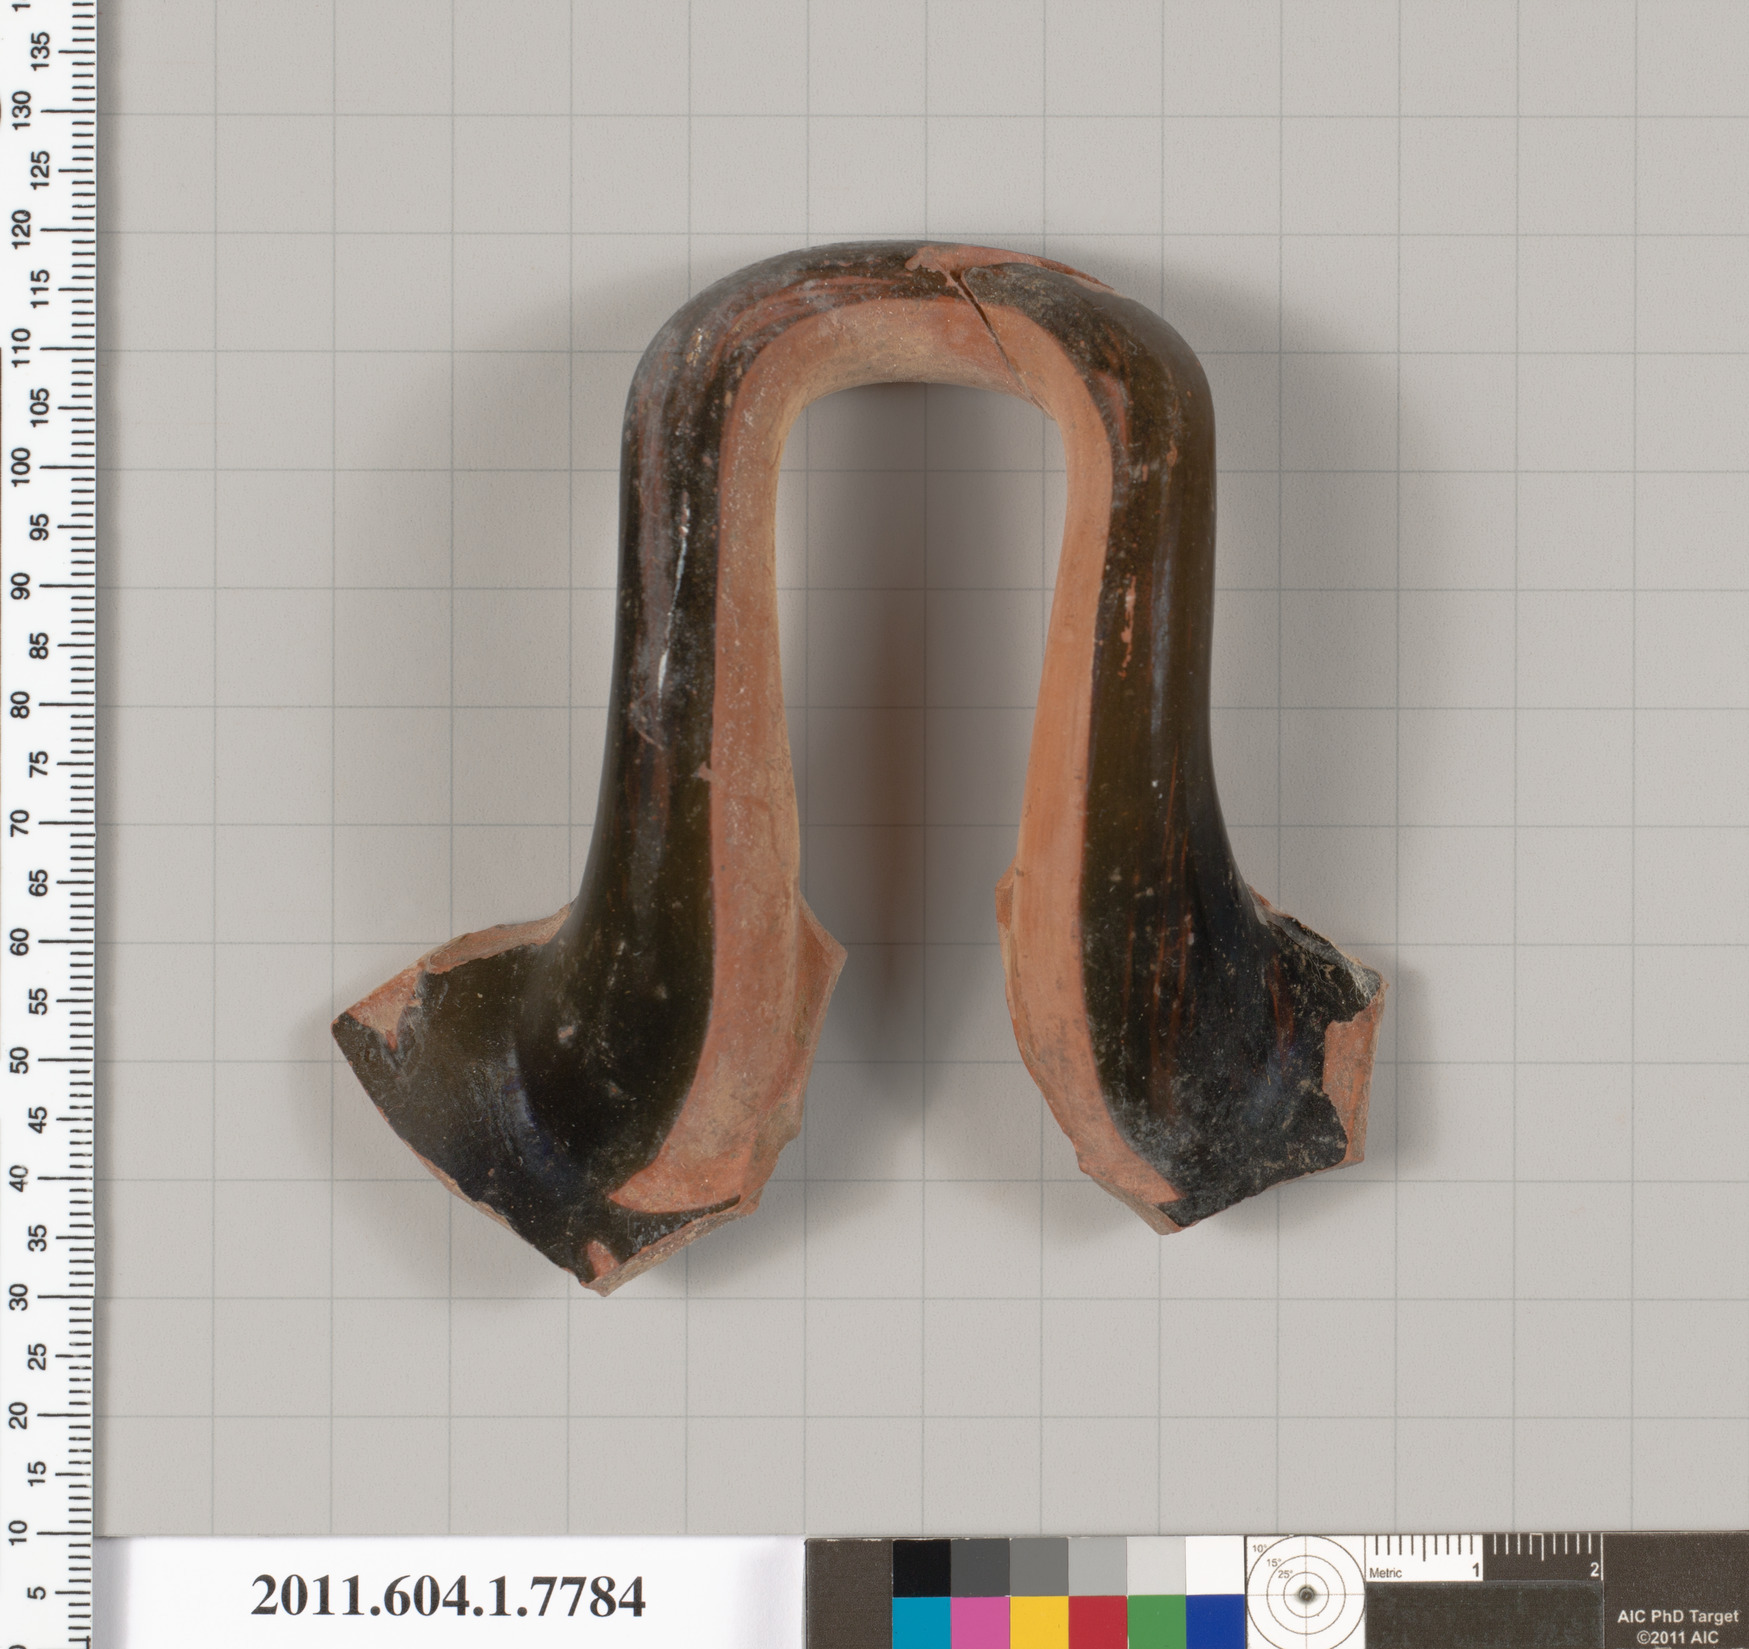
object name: kylix fragment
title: Terracotta fragment of a kylix (drinking cup)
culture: greek, attic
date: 460-450 BCE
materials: terracotta